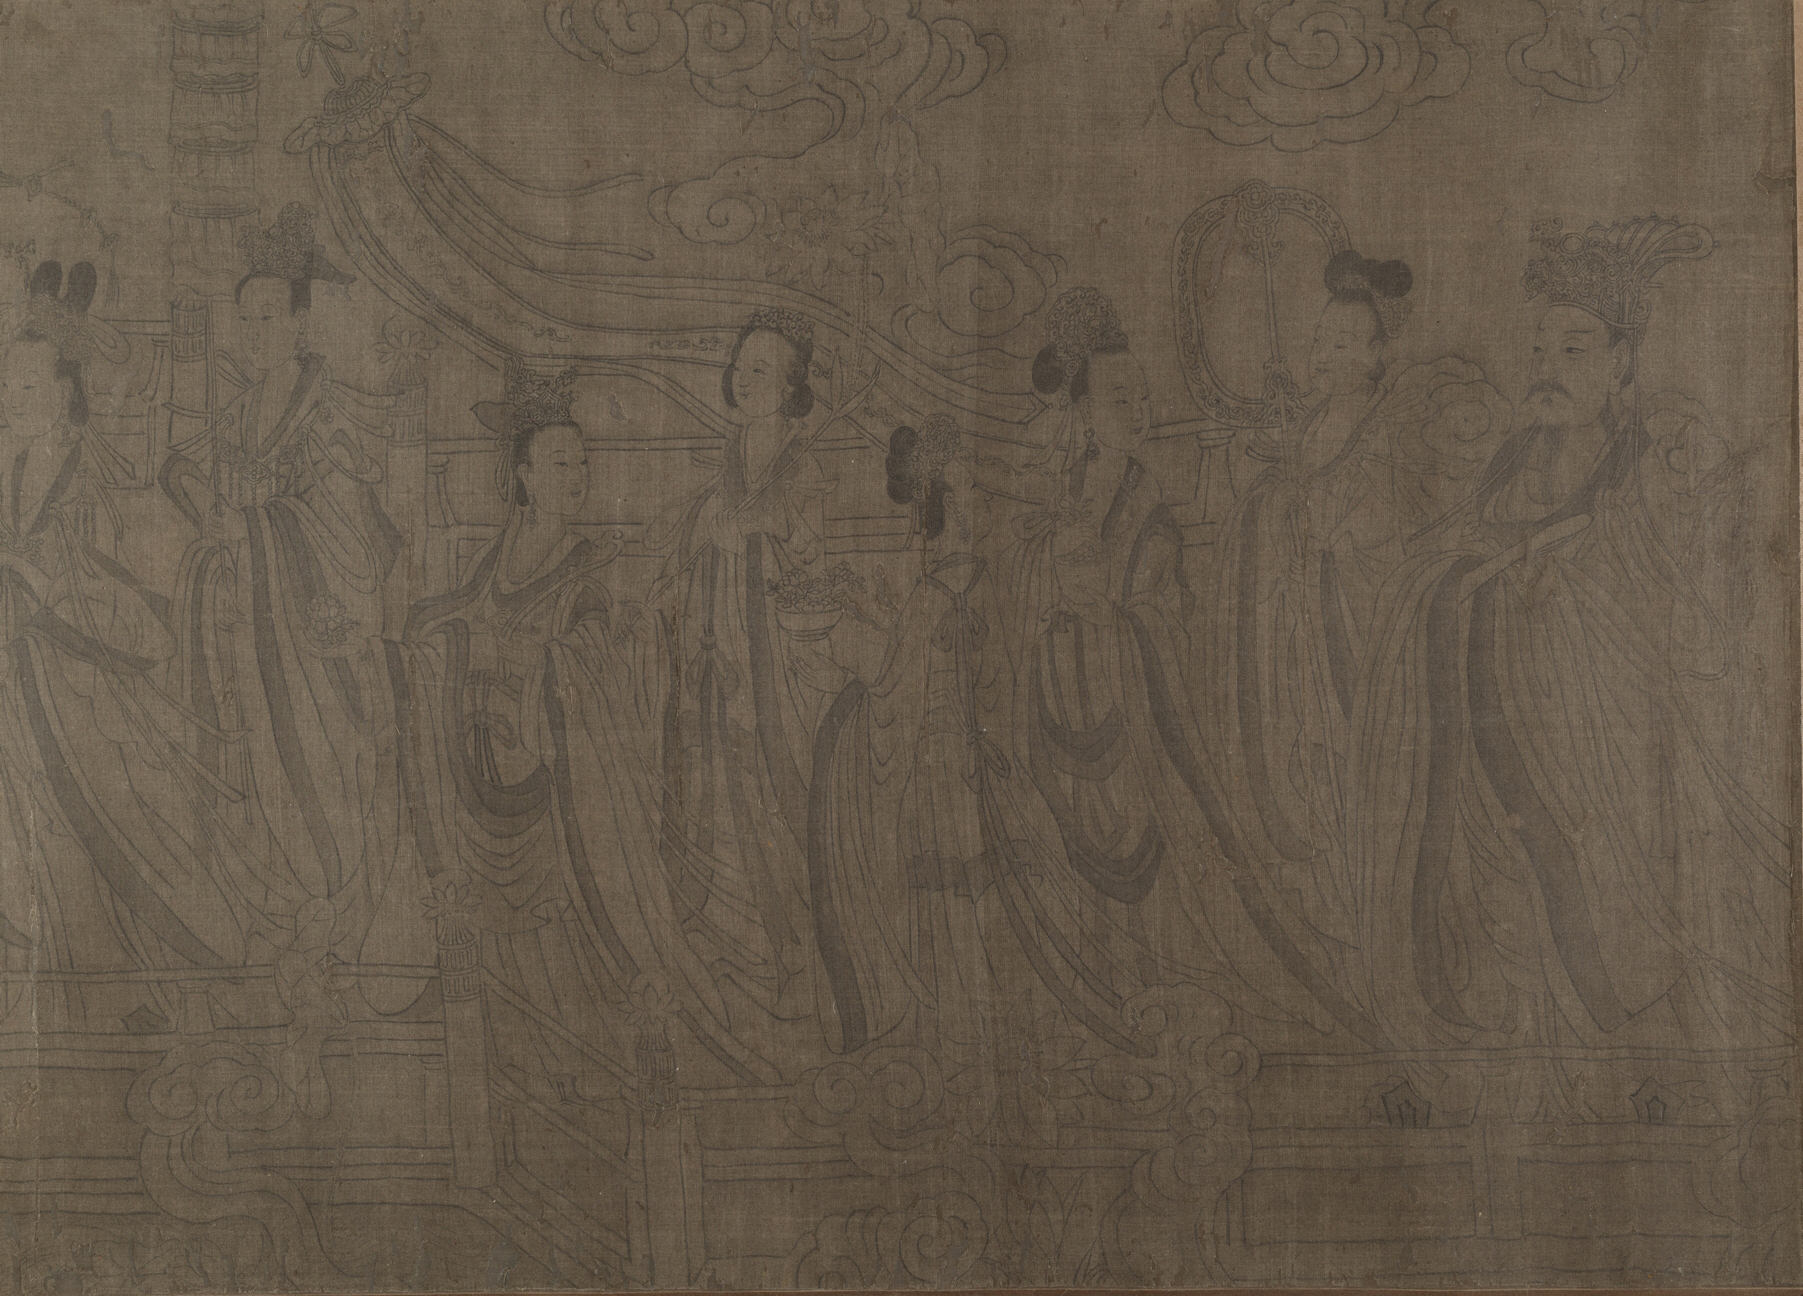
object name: handscroll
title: The Five Rulers at the New Year's Reception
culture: chinese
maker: unidentified artist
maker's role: artist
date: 1368-1644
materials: ink, silk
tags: human figures